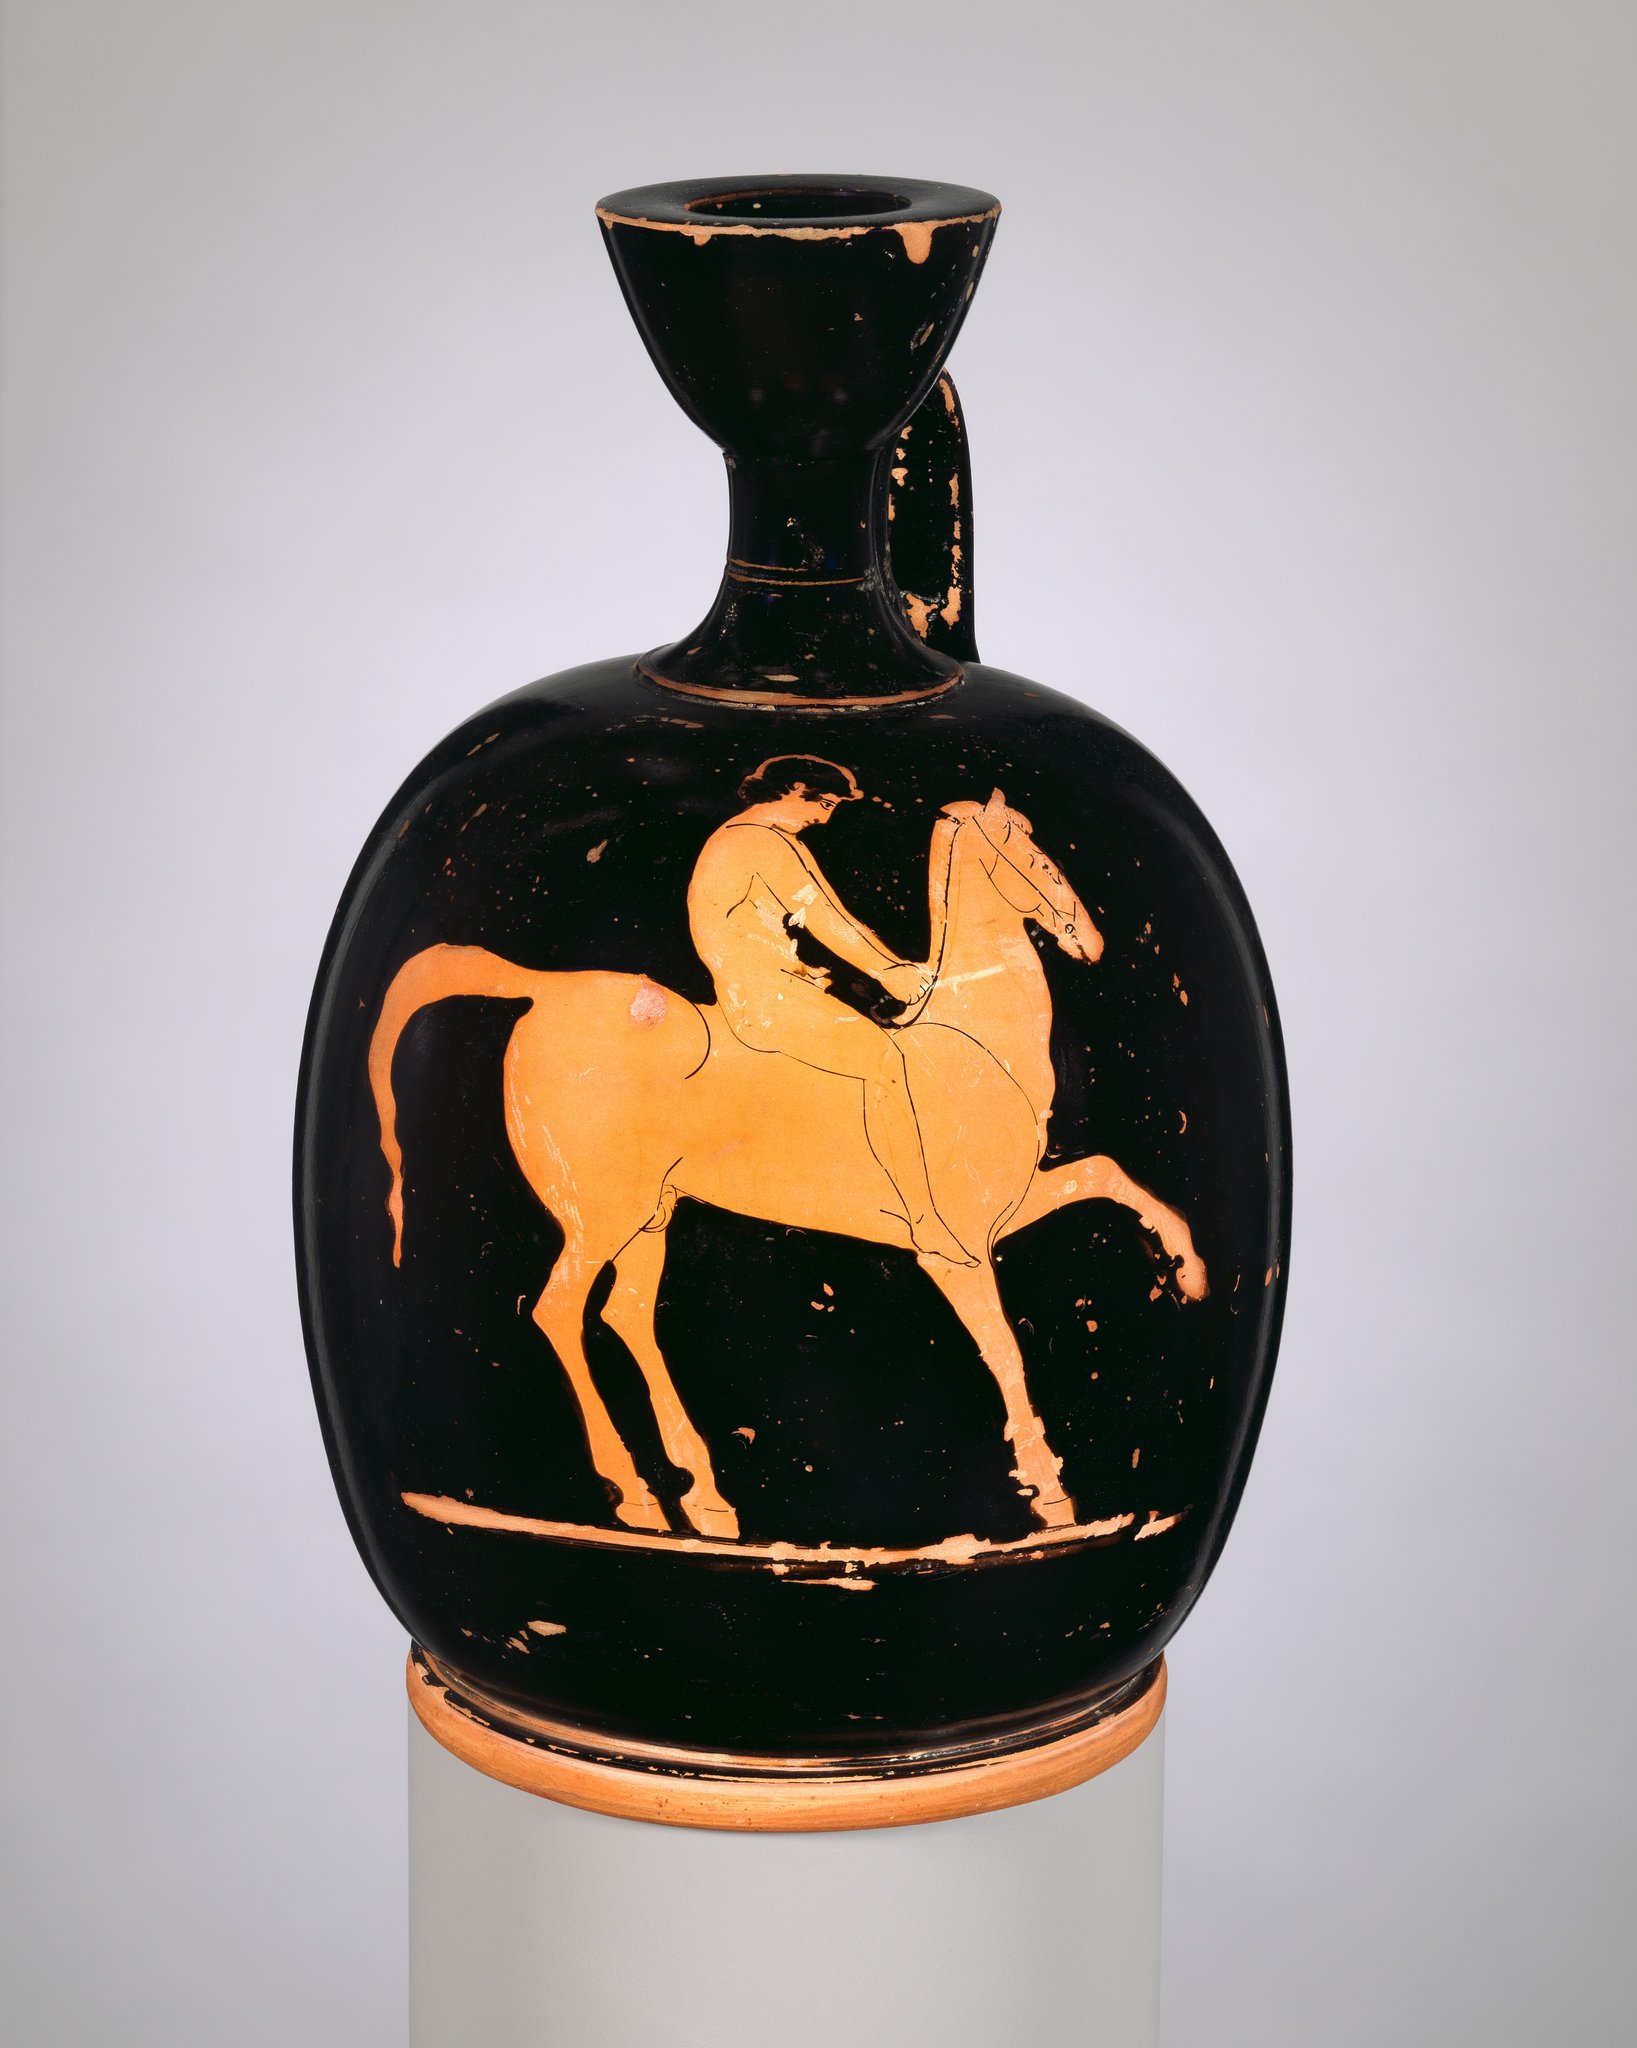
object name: squat lekythos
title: Terracotta squat lekythos (oil flask)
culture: greek, attic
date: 430-420 BCE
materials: terracotta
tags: male nudes,horses